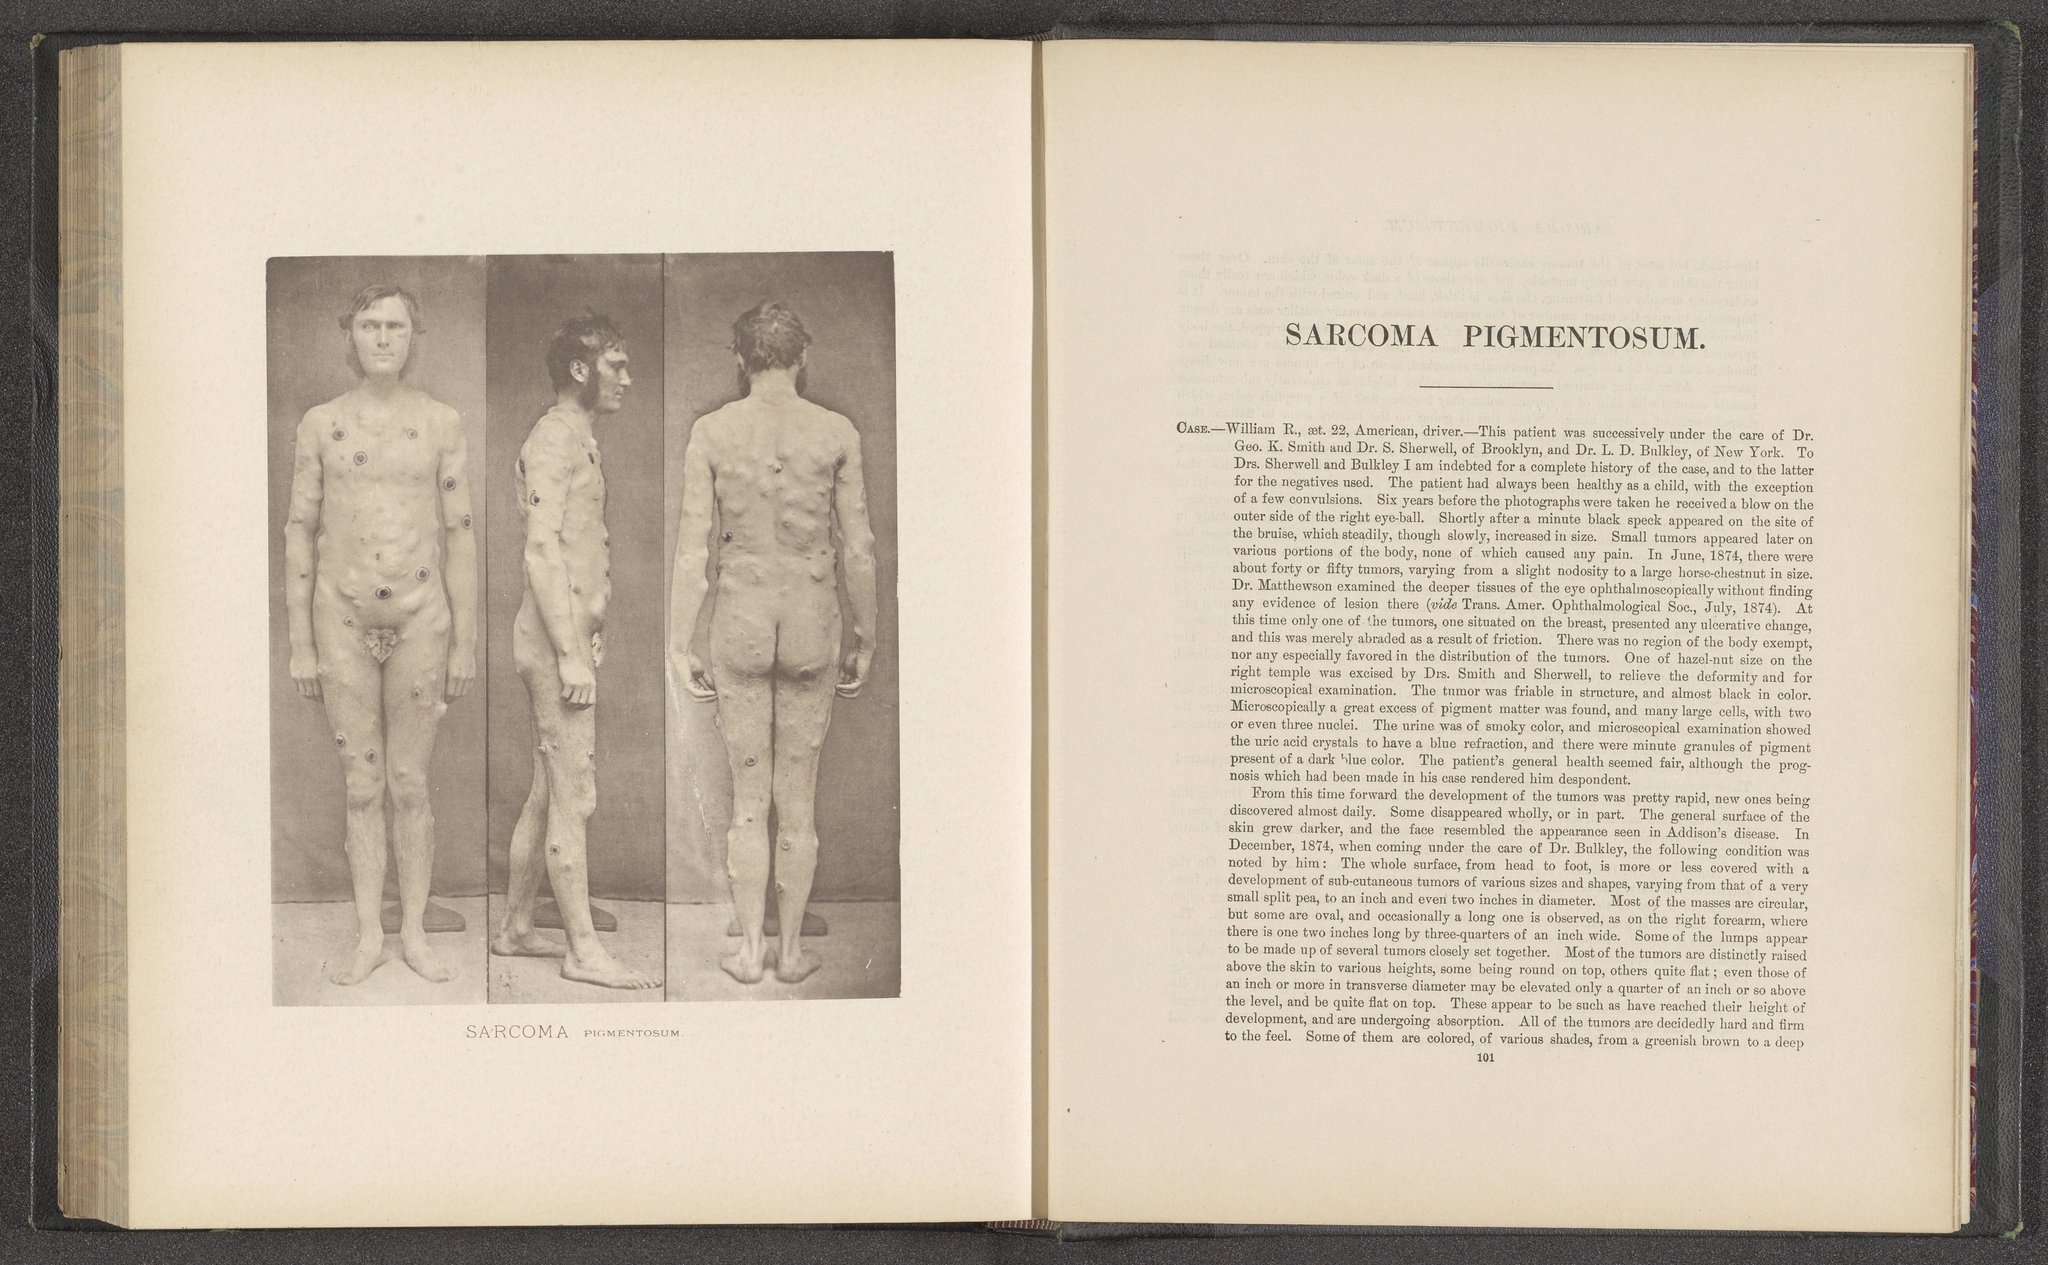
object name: page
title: Patiënt lijdend aan de huidziekte 'sarcoma pigmentosum'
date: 1870-1881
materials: paper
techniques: photograph, hand coloring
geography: new york city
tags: skin and venereal diseases, adult man